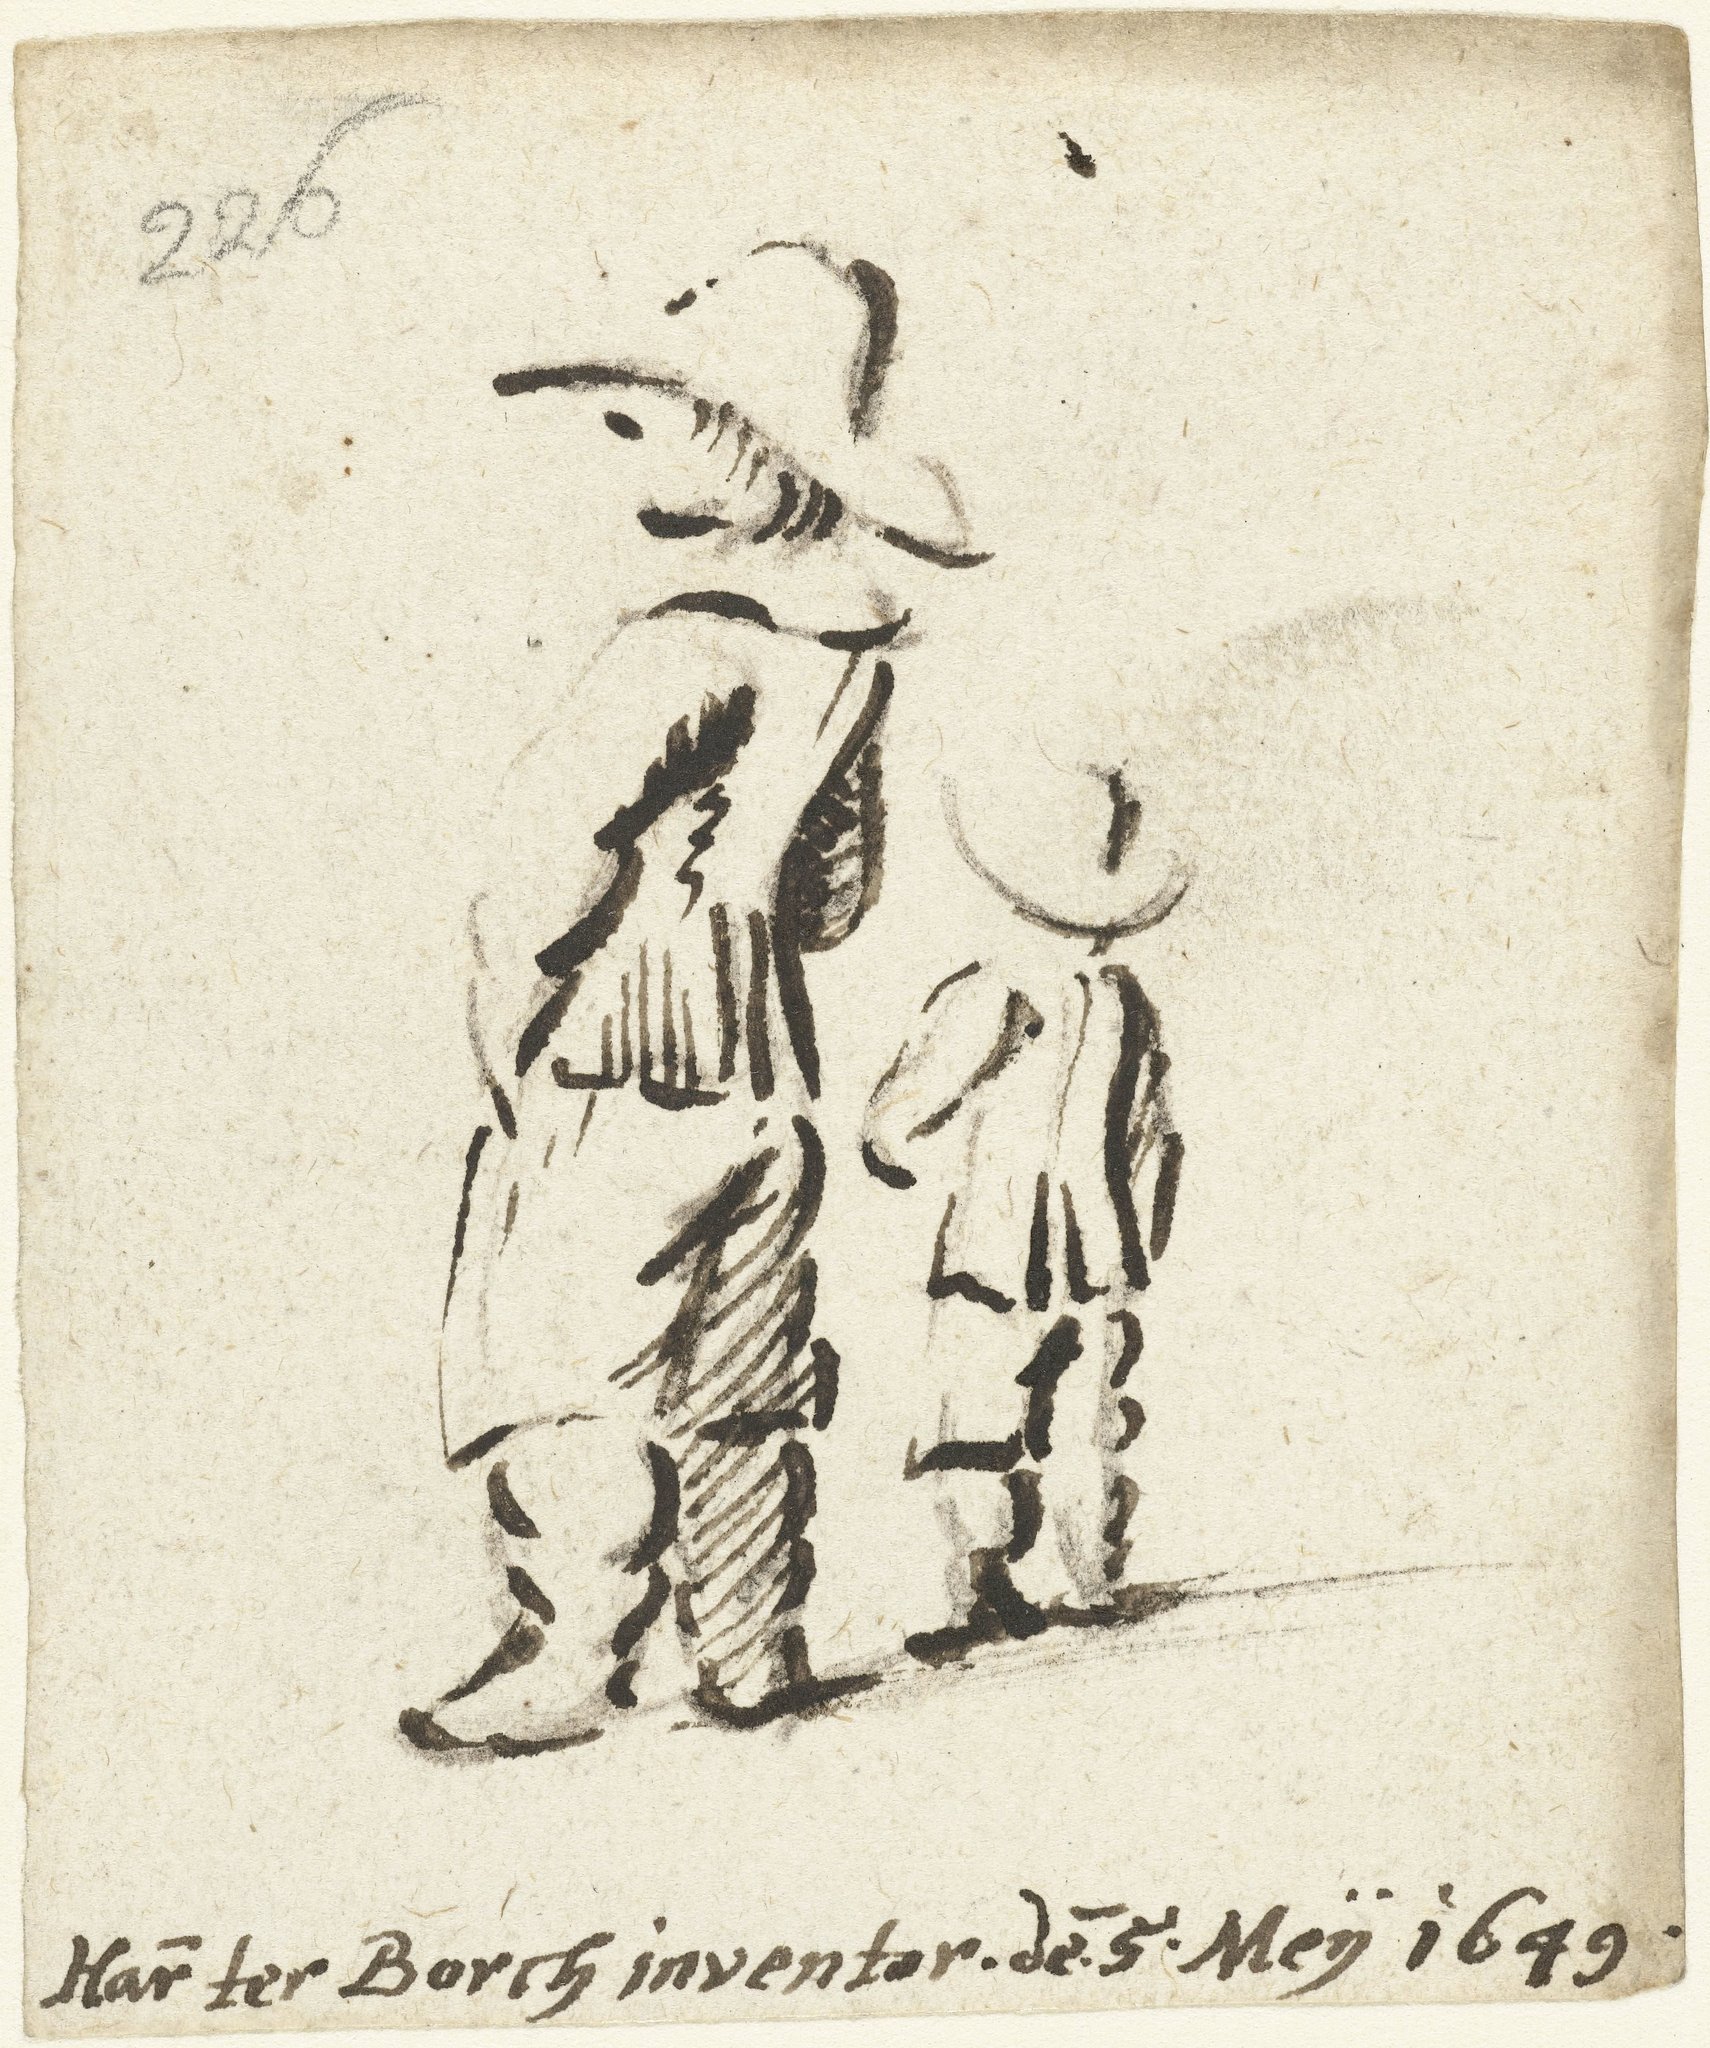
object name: drawing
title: Oudere jongen staand naast jongere jongen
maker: harmen ter borch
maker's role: draughtsman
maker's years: 1638-1677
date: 1649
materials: ink, paper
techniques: brush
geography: zwolle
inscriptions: annotation: ‘Har[men] ter Borch inventor. de[n]. 5.Mey 1649.’